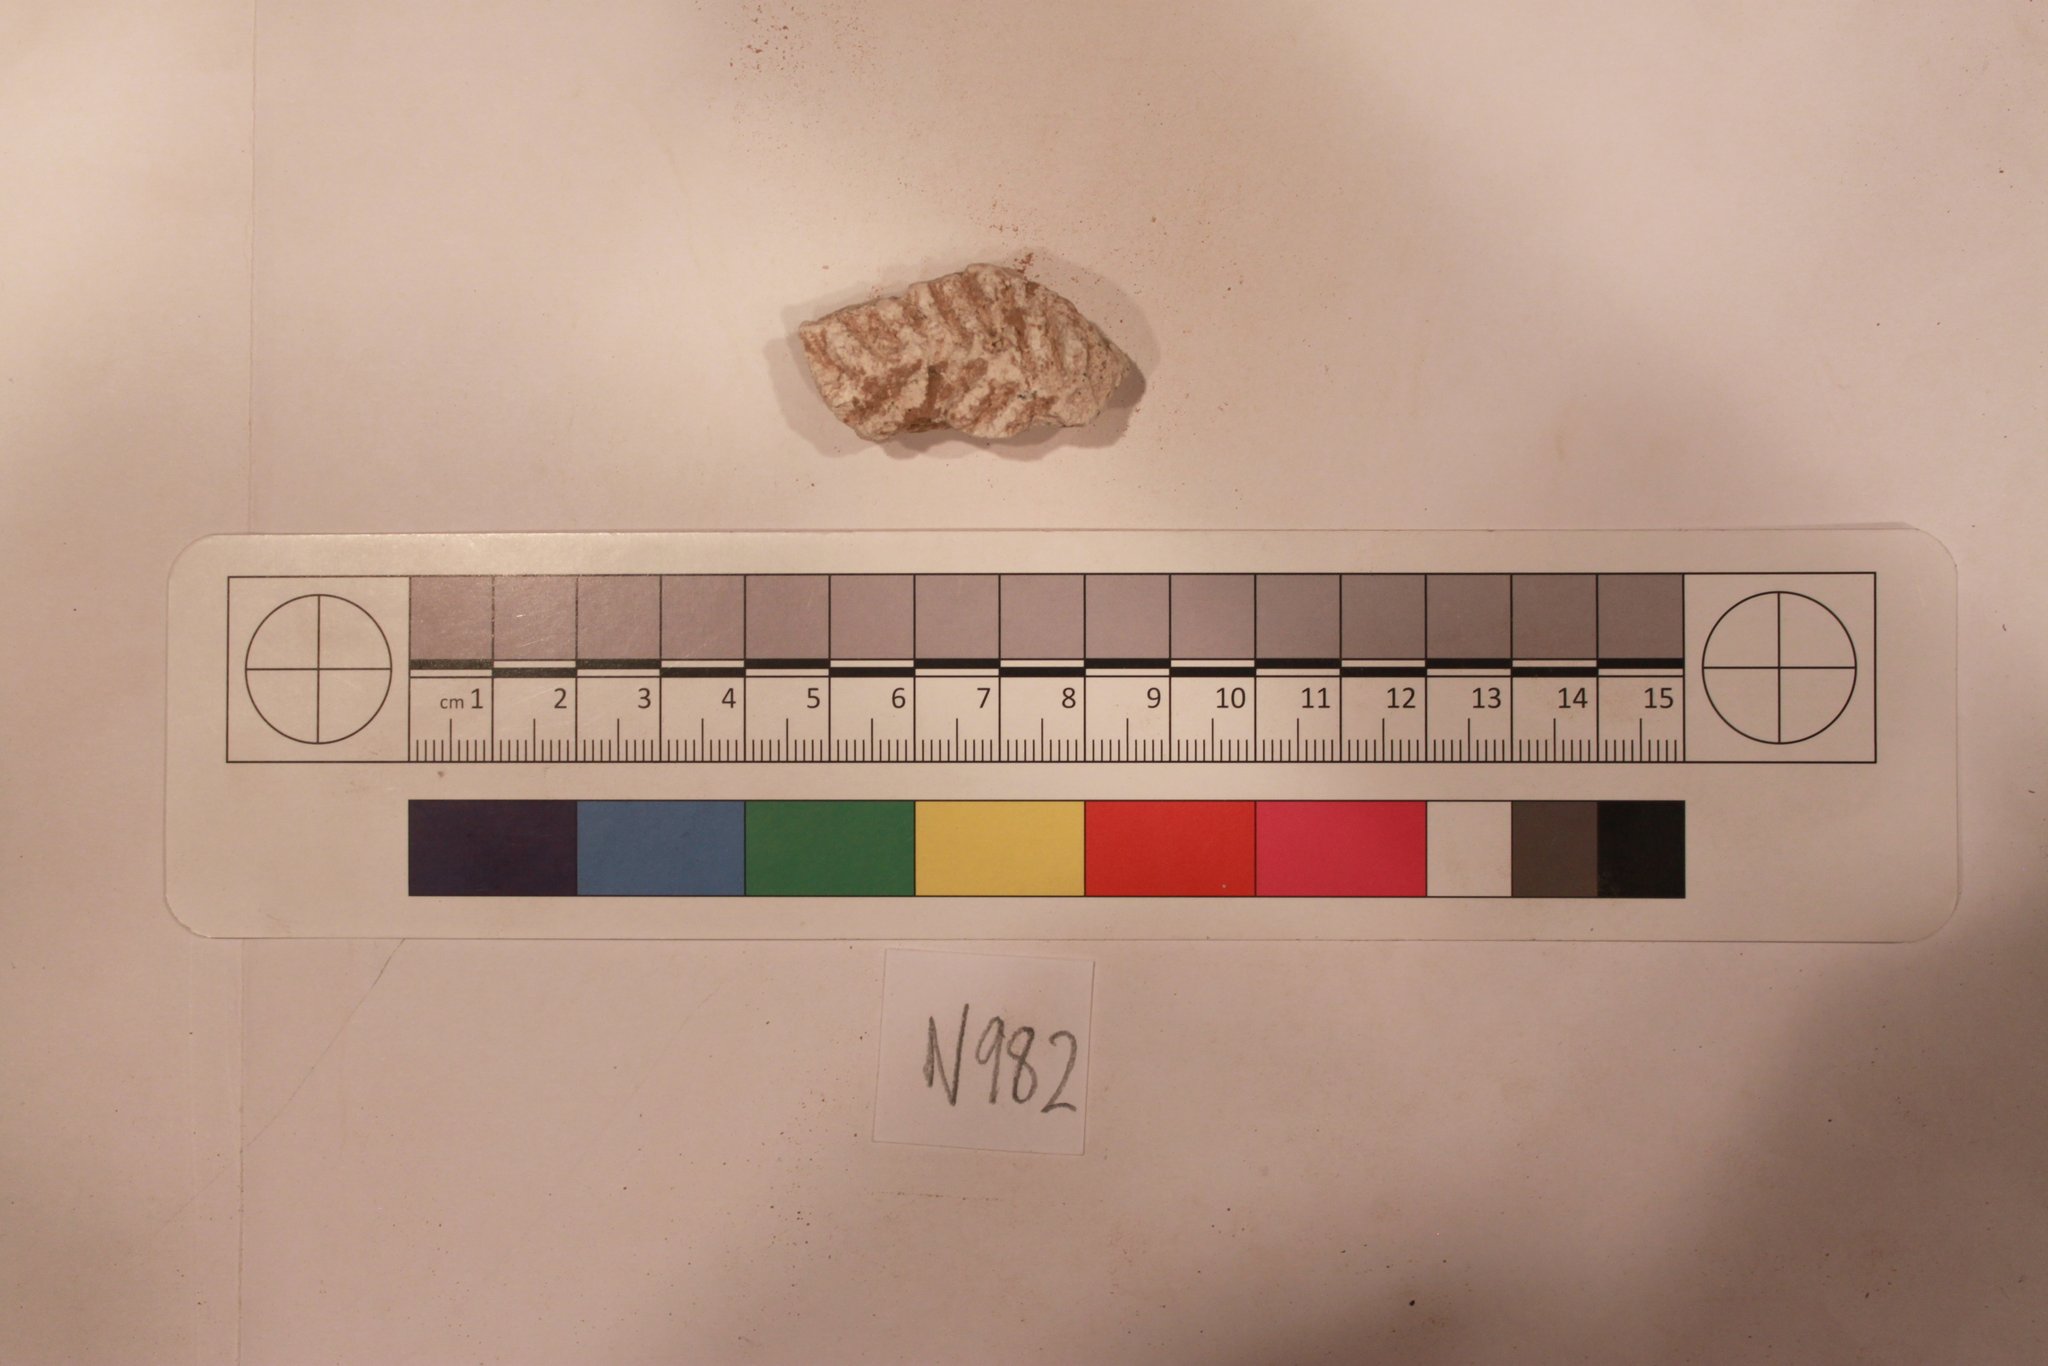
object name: fragment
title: Stucco Fragment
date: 701-1200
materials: plaster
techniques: carving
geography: iran